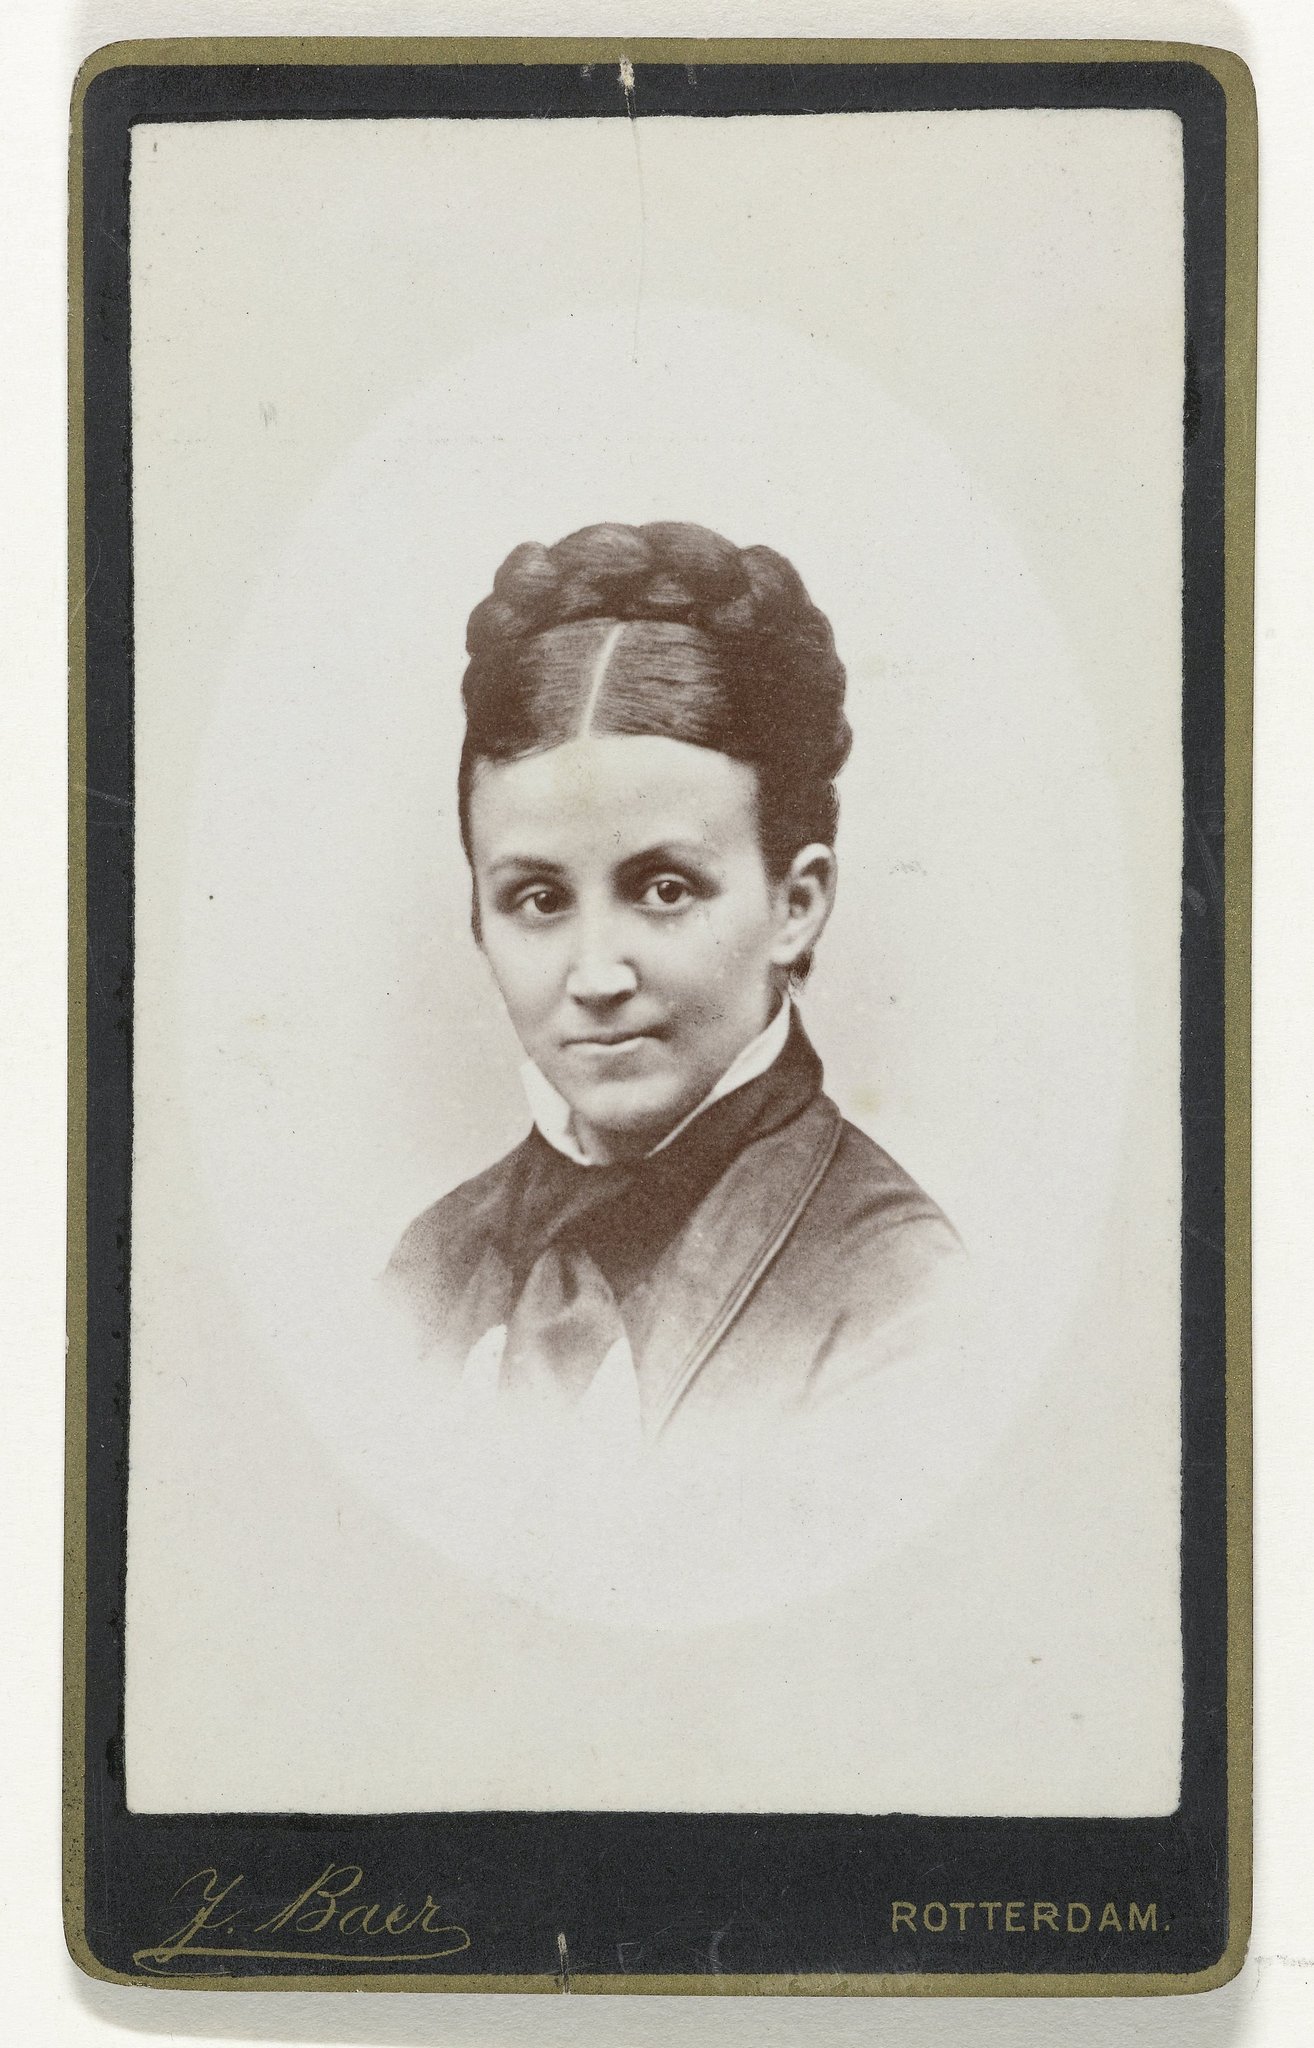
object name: carte de visite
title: Portret van een vrouw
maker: johannes baer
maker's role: fotograaf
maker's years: 1840-1912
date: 1879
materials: cardboard, paper, photographic support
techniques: albumen print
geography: rotterdam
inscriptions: address: ‘J. Baer/Photographe/Schiedamsche Singel 55/Rotterdam’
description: Kop van een vrouw met opgestoken haar, in ovaal, zonder achtergrond.